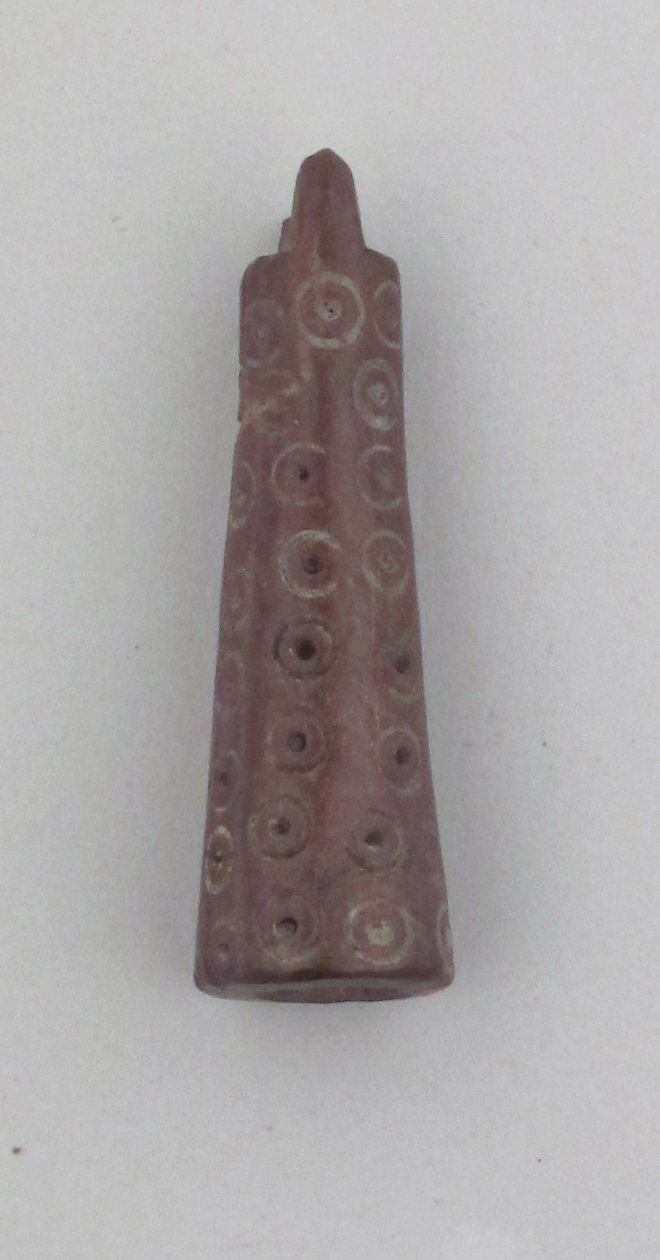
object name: plumbline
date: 7000 BCE-330 CE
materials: bone, ivory